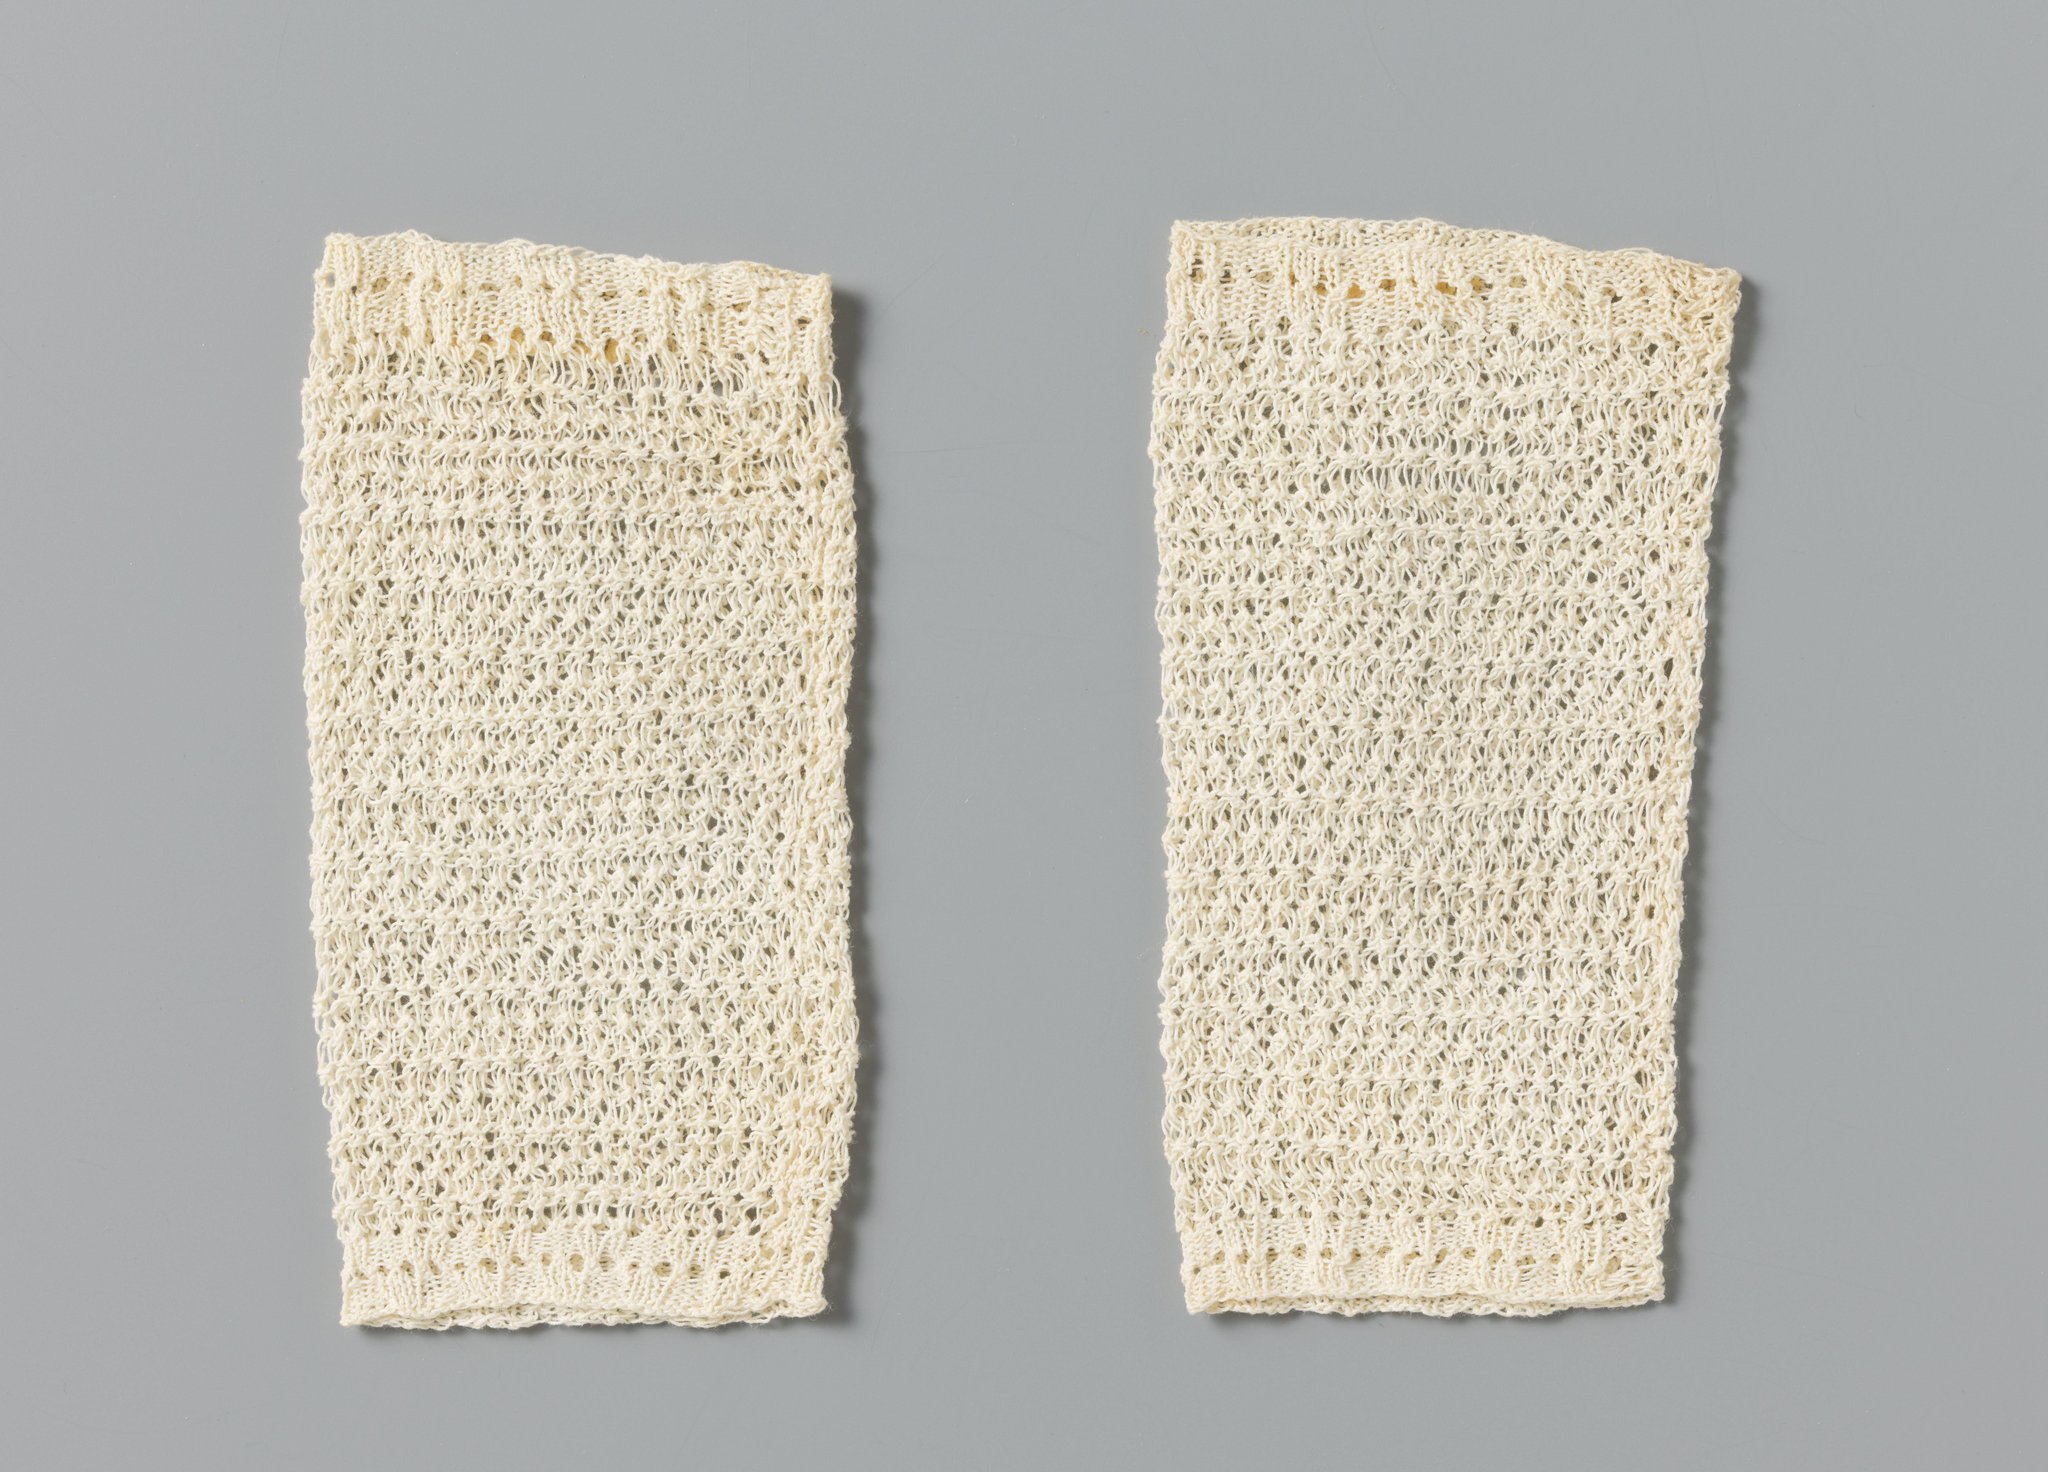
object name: mitt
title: Gebreide mitaine van ongebleekte katoen met ajourwerk en een boord met boordsteek en open rondjes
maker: Anonymous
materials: cotton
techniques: embroidery, knitting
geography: europe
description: Vaas van porselein, versierd in reliëf in pâte-tur-pâte-techniek met vijf klaprozen in rose en blauwgrijs aan groene stengels, en met langs de mondrand twaalf groene vruchtenknoppen aan de tengels van dezelfde bloem. Merken: fabrieksmerk in groen, KL. in groen; ingegrift R.R. 4152. Decor van Karl Lindström.